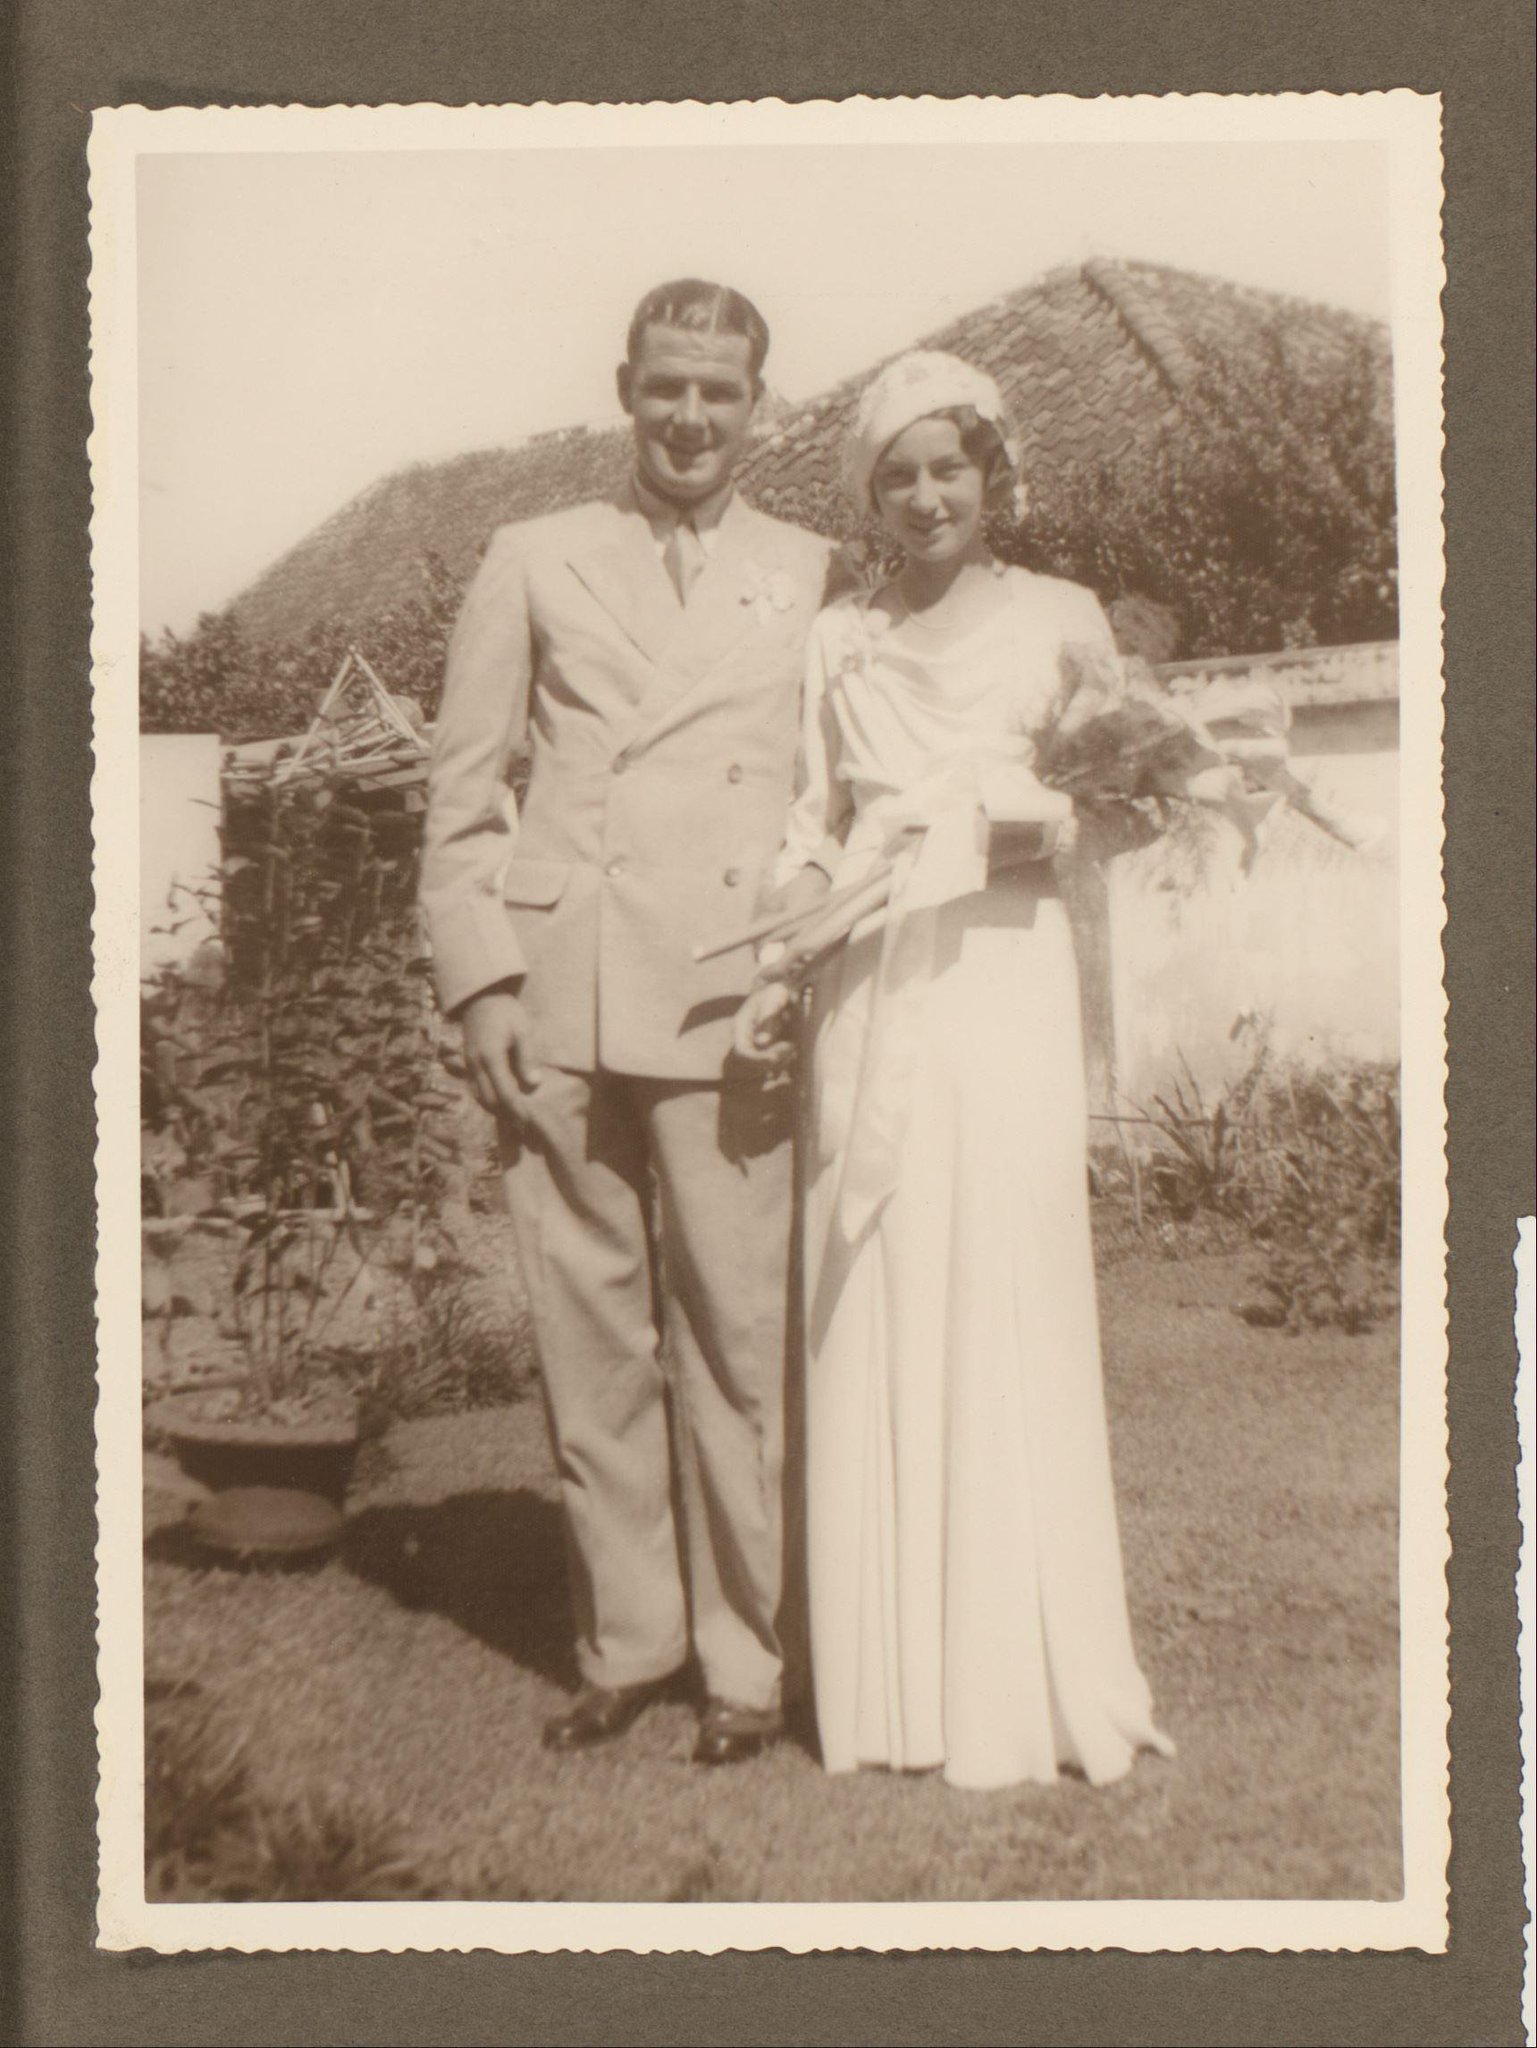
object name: album leaf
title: Portret van Edward Burch en Ada Krüseman op hun bruiloft, Bandoeng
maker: Anonymous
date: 1932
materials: paper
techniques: gelatin silver print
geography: bandung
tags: london, historical persons, bride and groom in wedding-dress